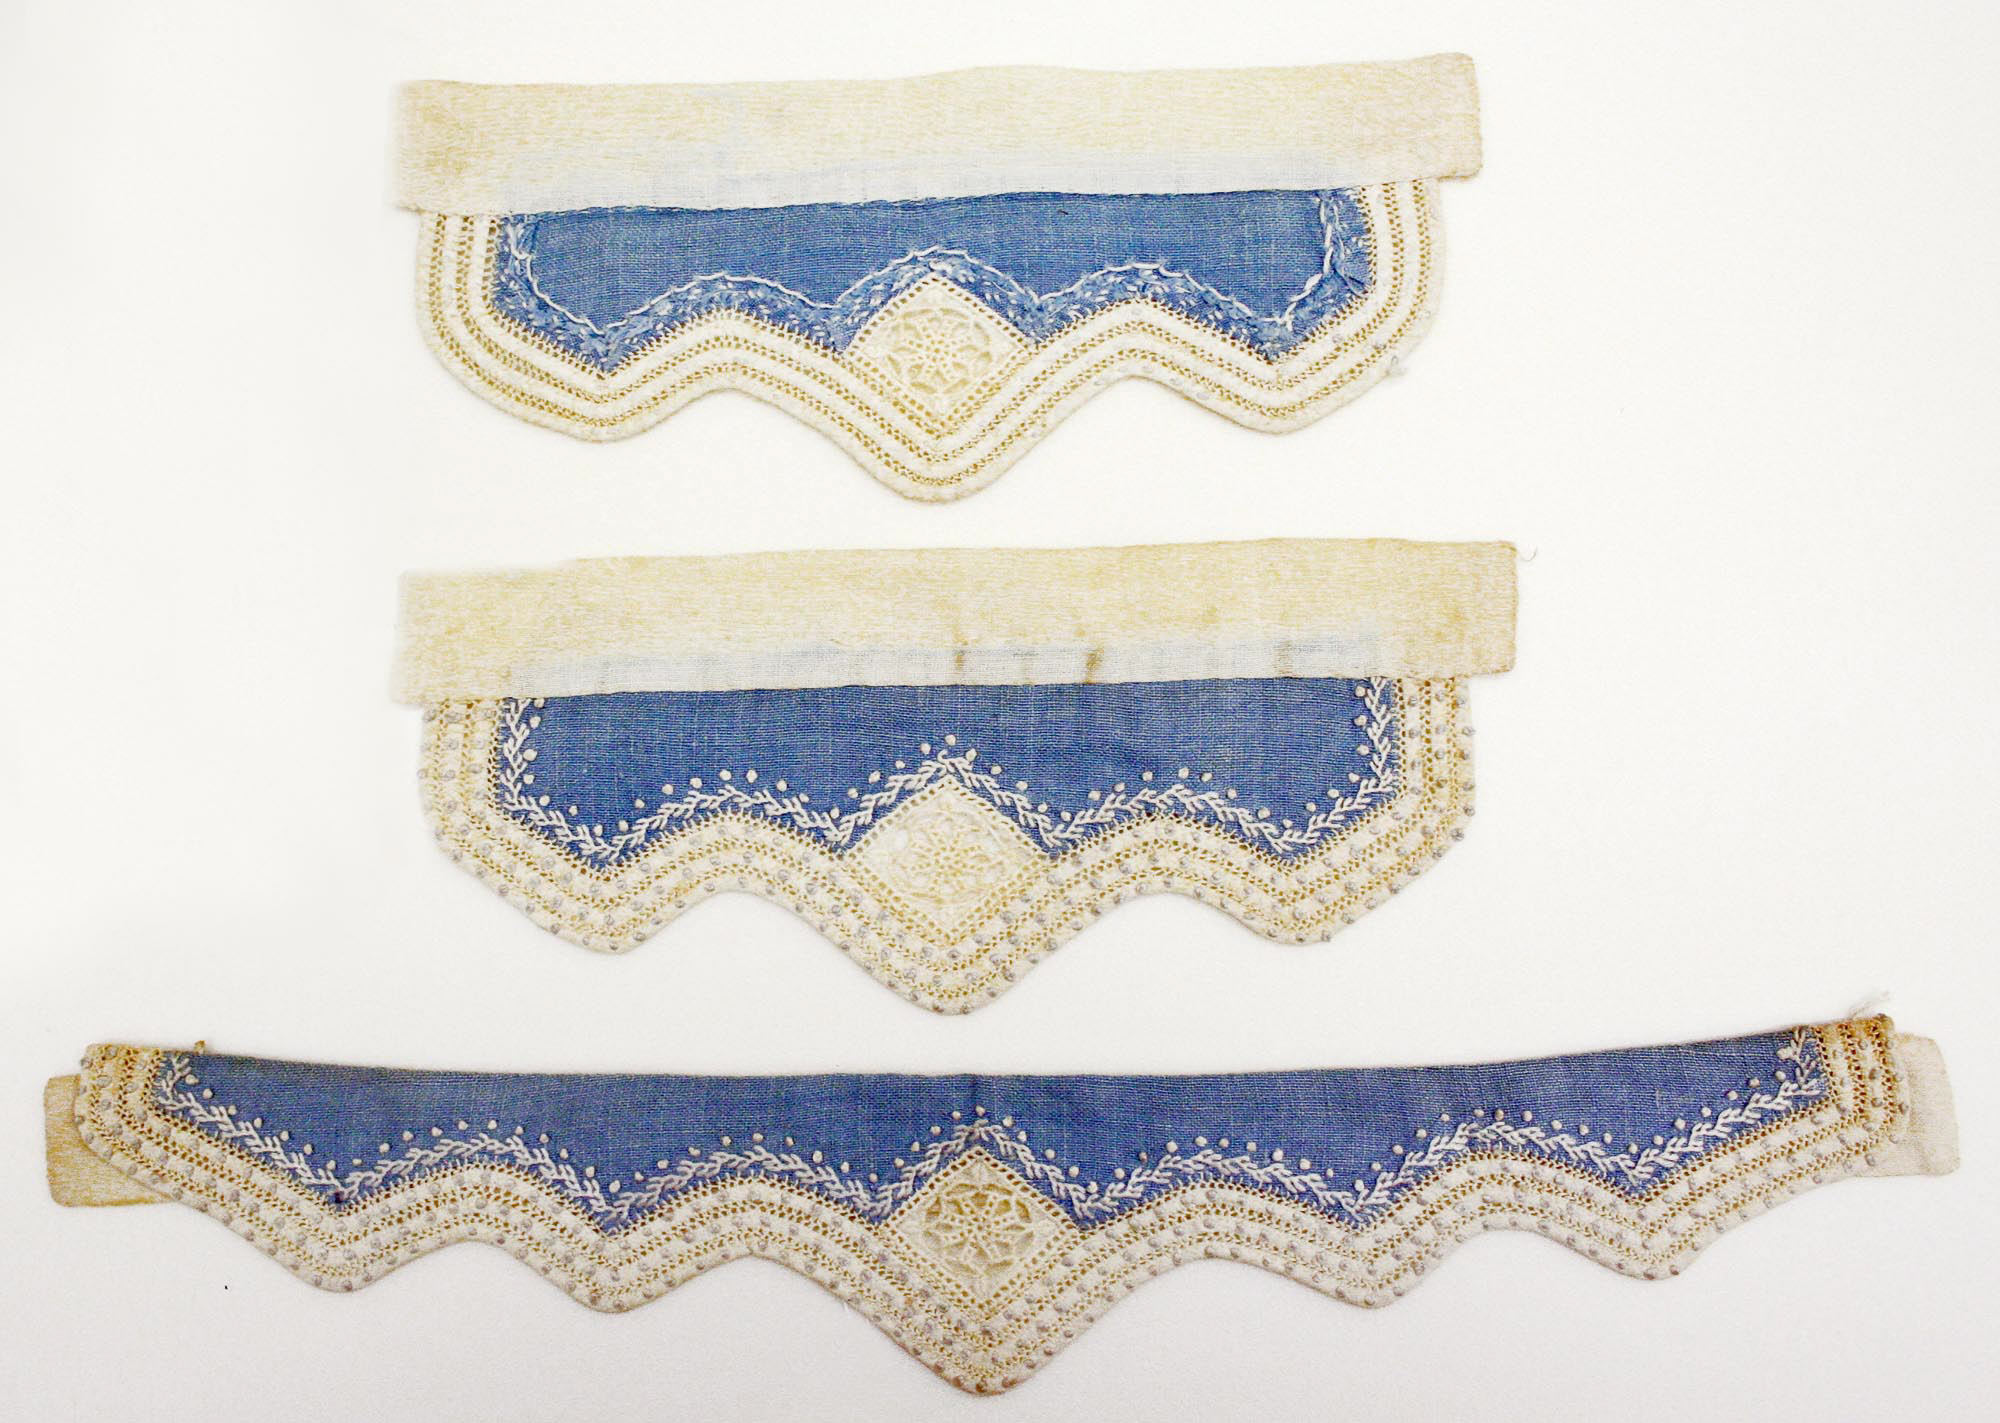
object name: accessory set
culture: american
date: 1700-1943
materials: cotton, linen